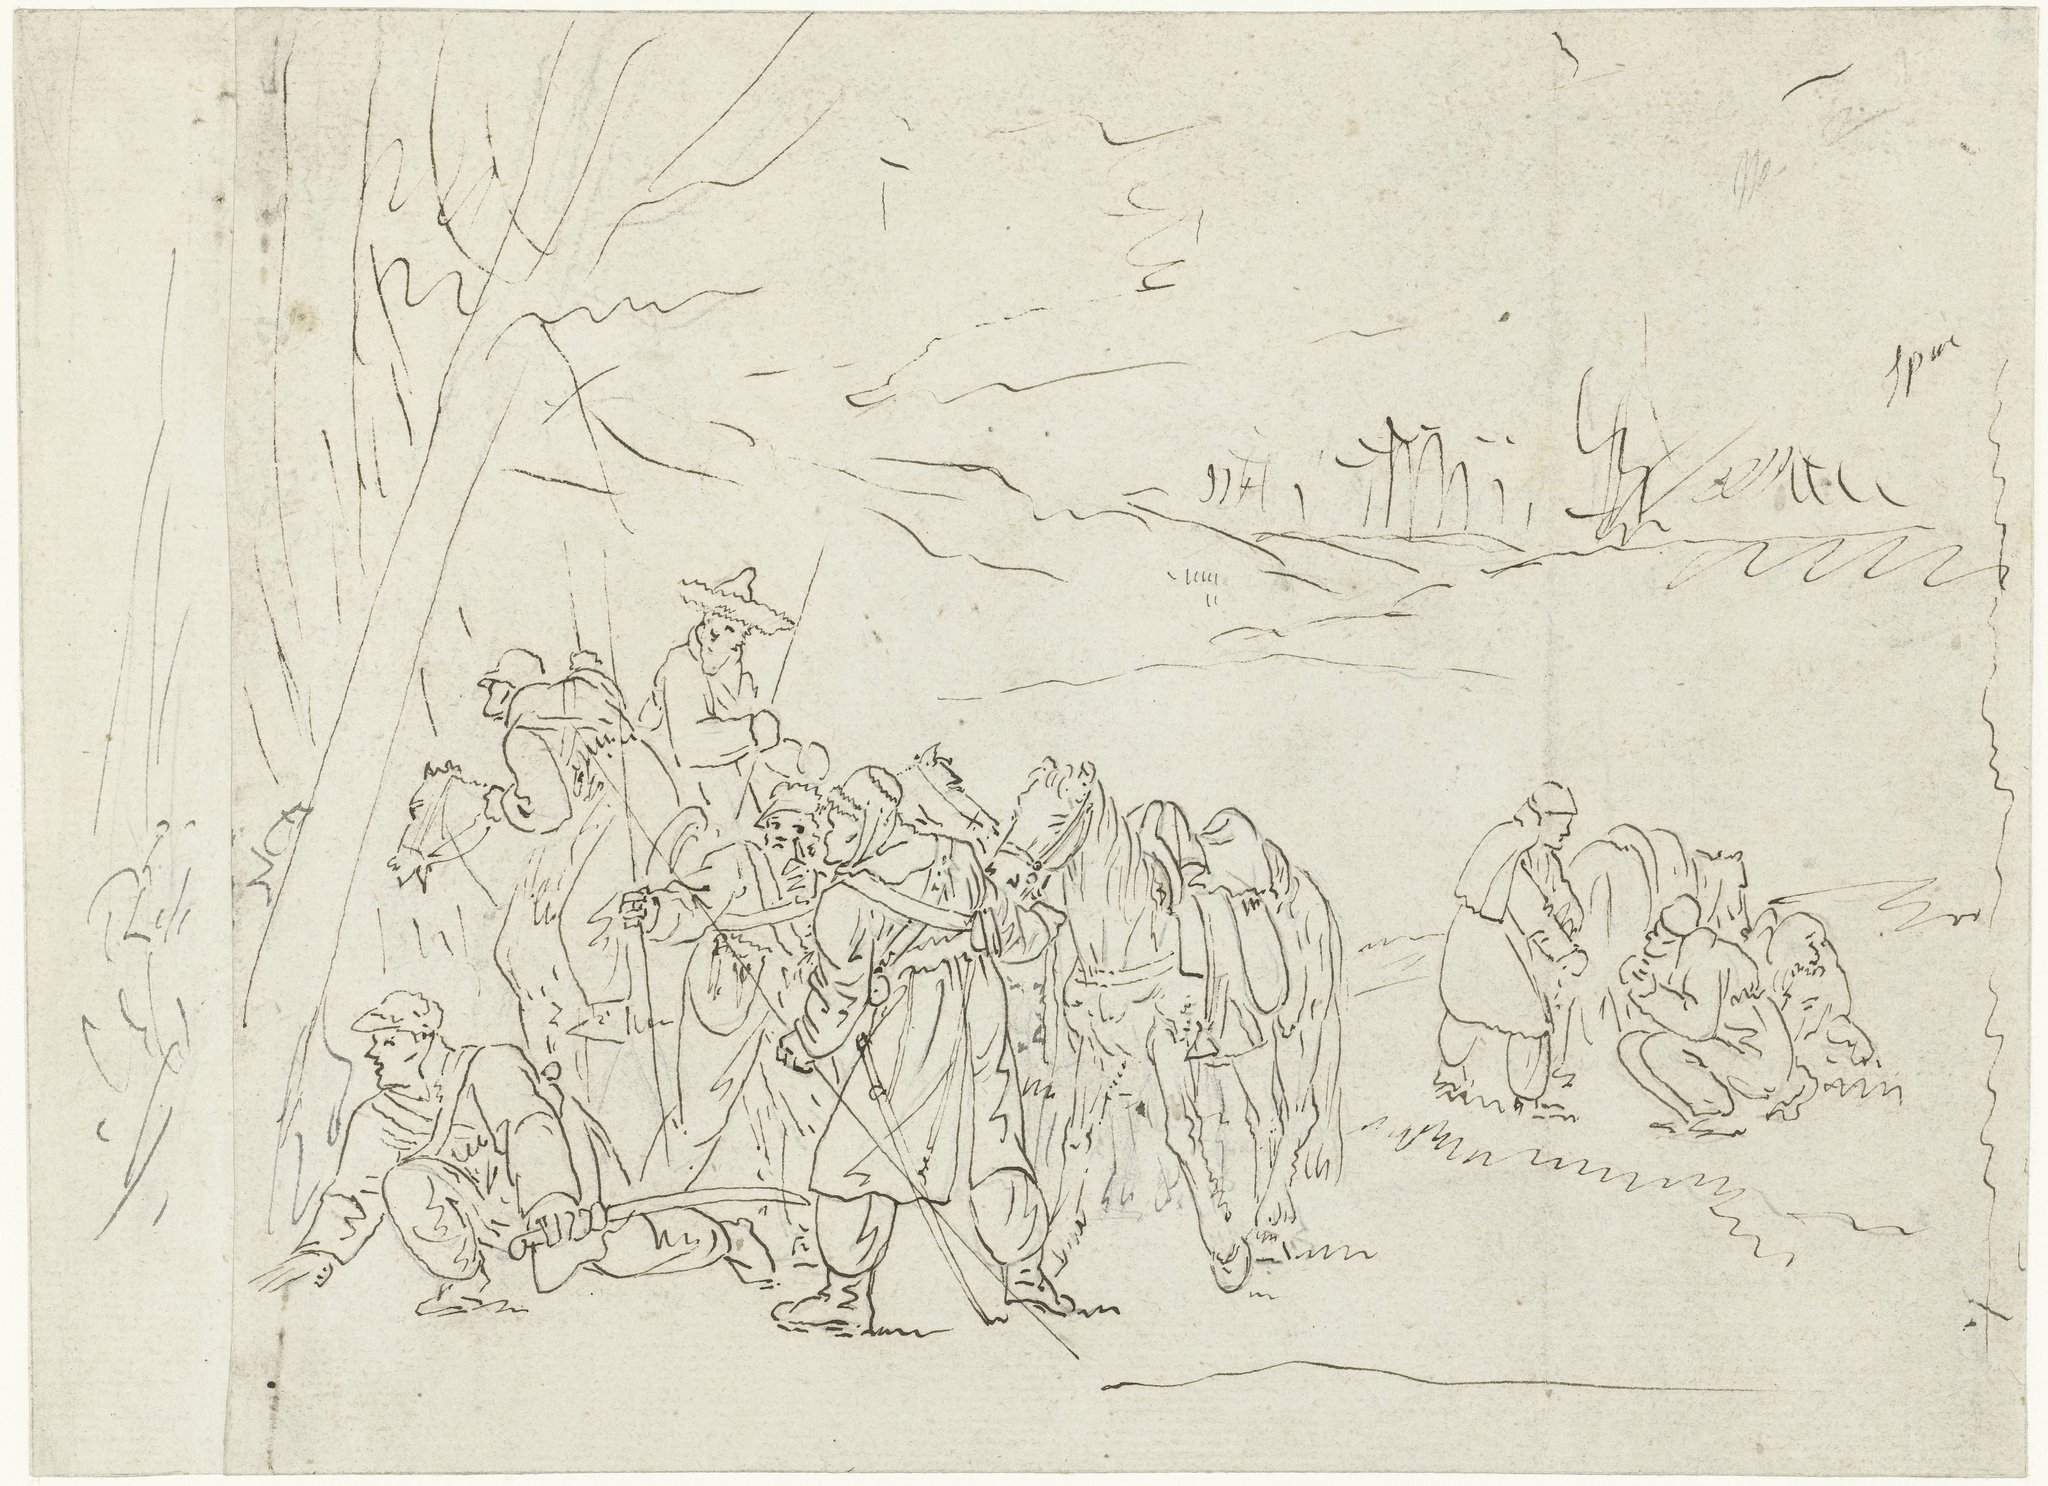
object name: drawing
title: Kozakken in een hinderlaag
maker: louis moritz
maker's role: draughtsman, painter, print maker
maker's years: 1773-1850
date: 1783-1850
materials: ink, paper, pencil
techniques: pen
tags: land forces (+ cavalry, horsemen), surprise attack (from ambush)